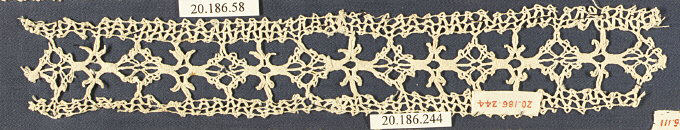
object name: insertion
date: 1501-1600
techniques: lace